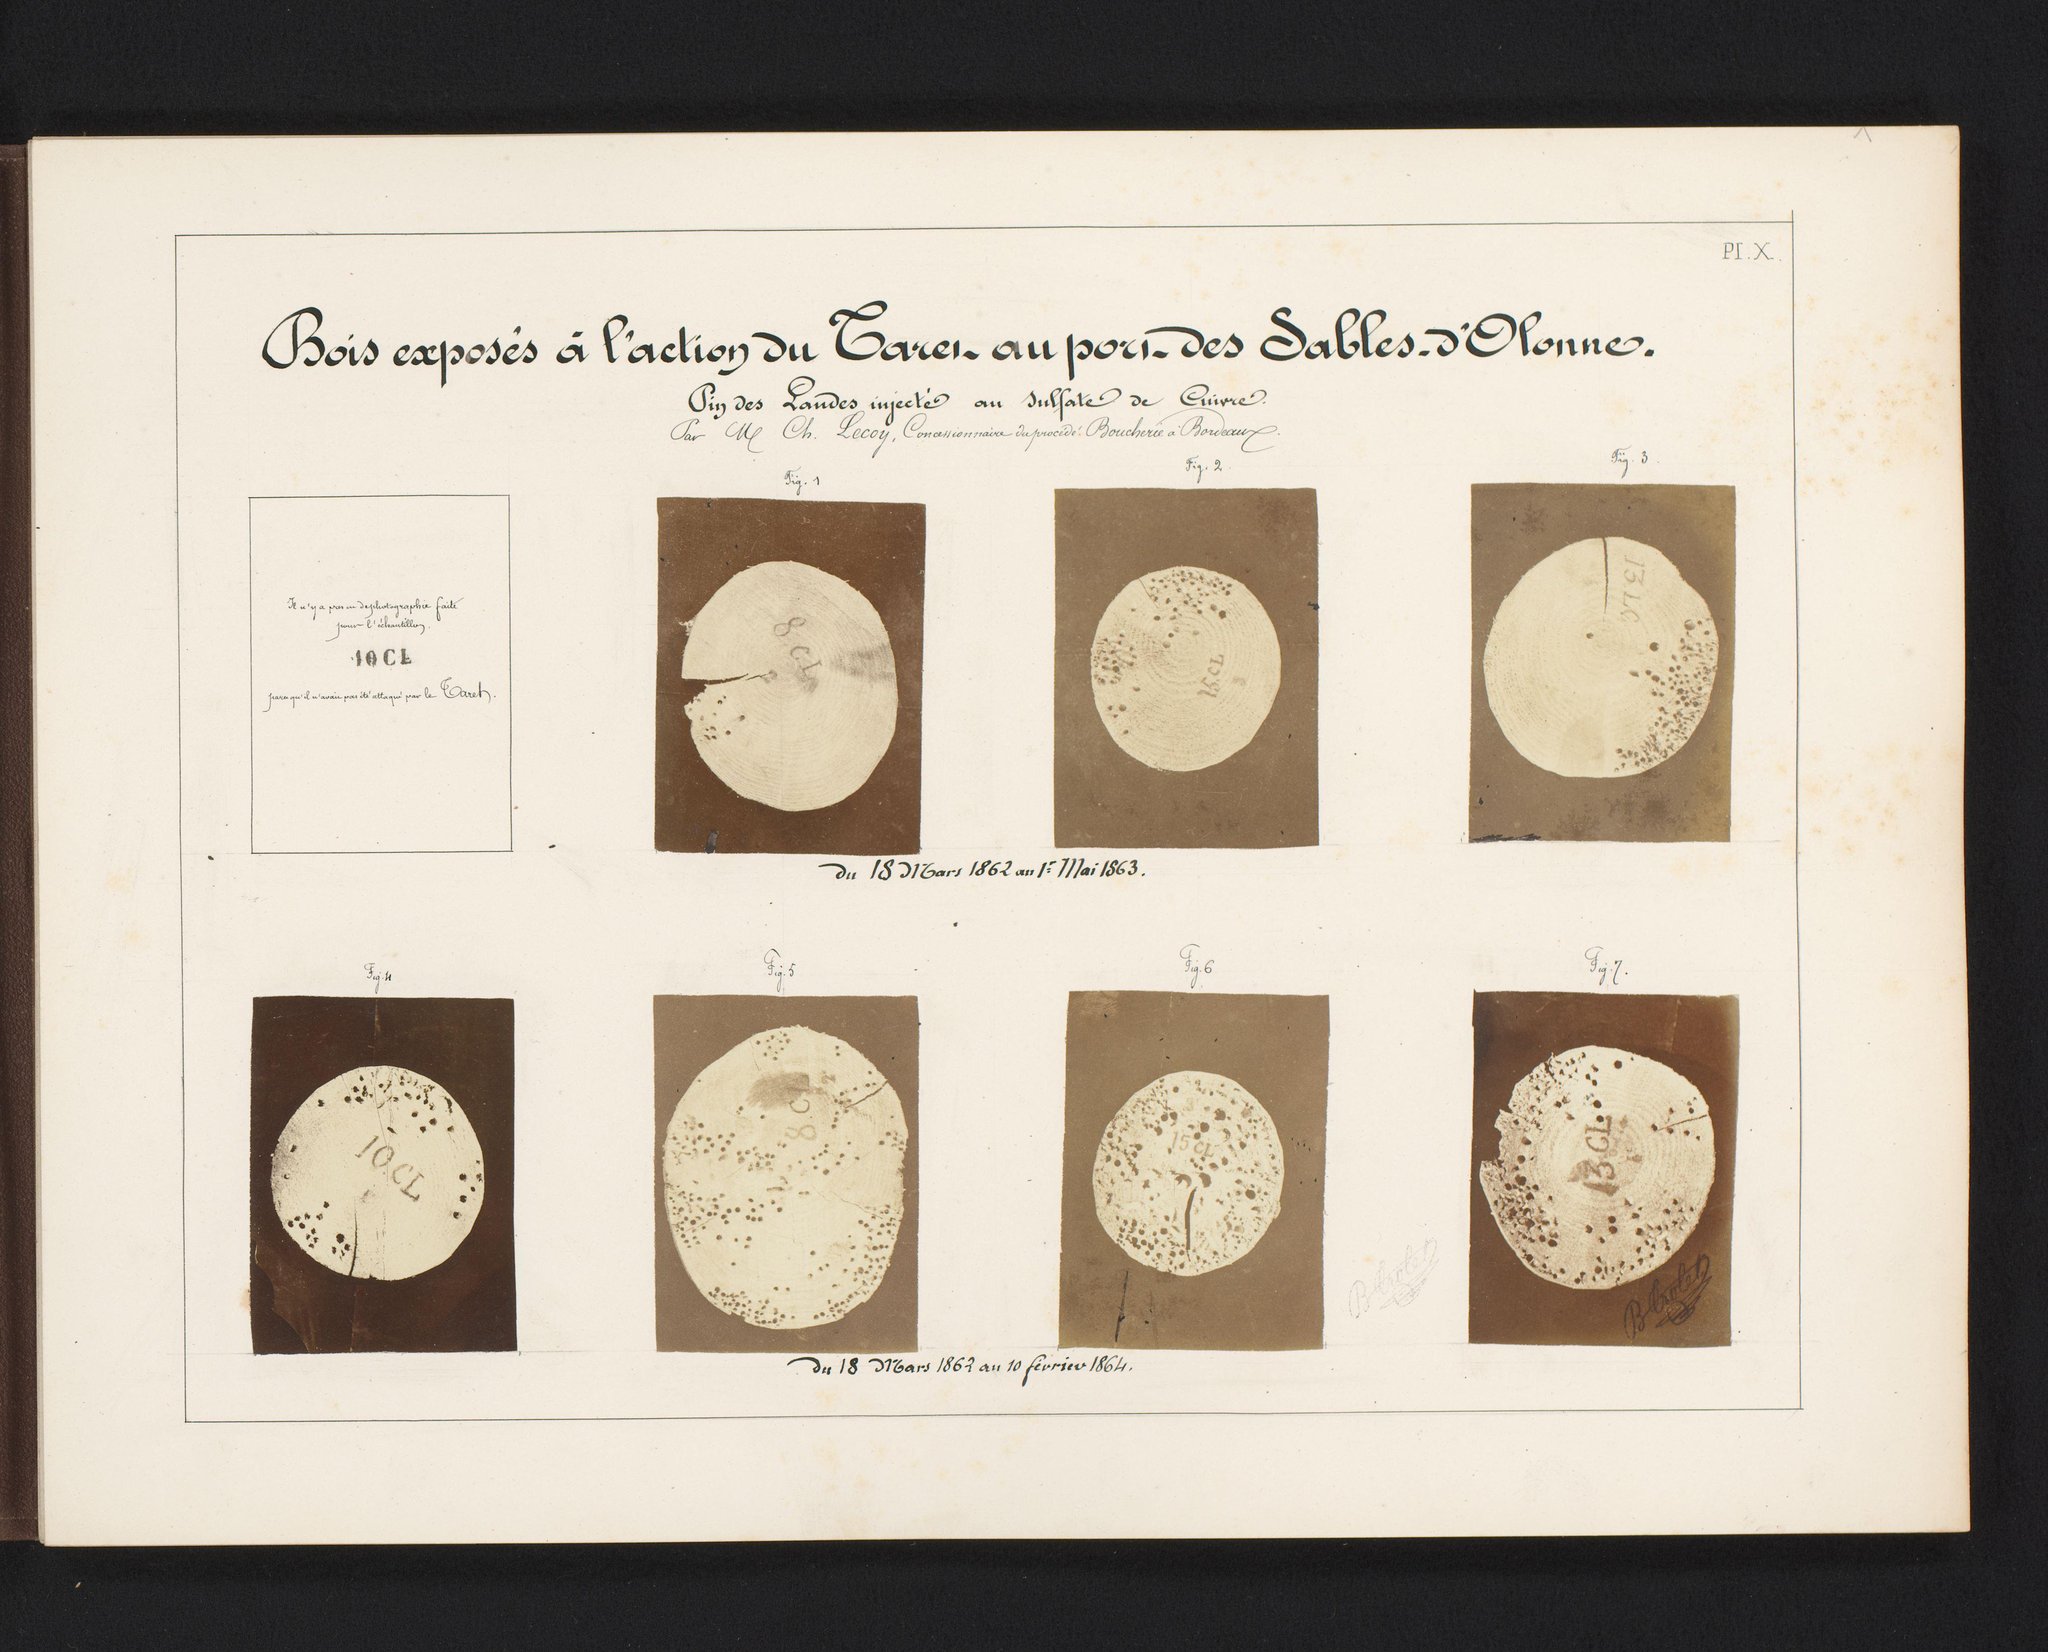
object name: photograph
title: Bois exposés à l'action du Taret au port des Sables-d'Olonne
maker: b. crolet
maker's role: fotograaf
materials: cardboard, photographic support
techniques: albumen print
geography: france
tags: worms, wood, timber ~ building material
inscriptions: signature: ‘B. Crolet’, annotation: ‘Pin des Landes injecté au sulfate de Cuivre/ (...) 10 fevrier 1864.’, number: ‘Pl. X.’